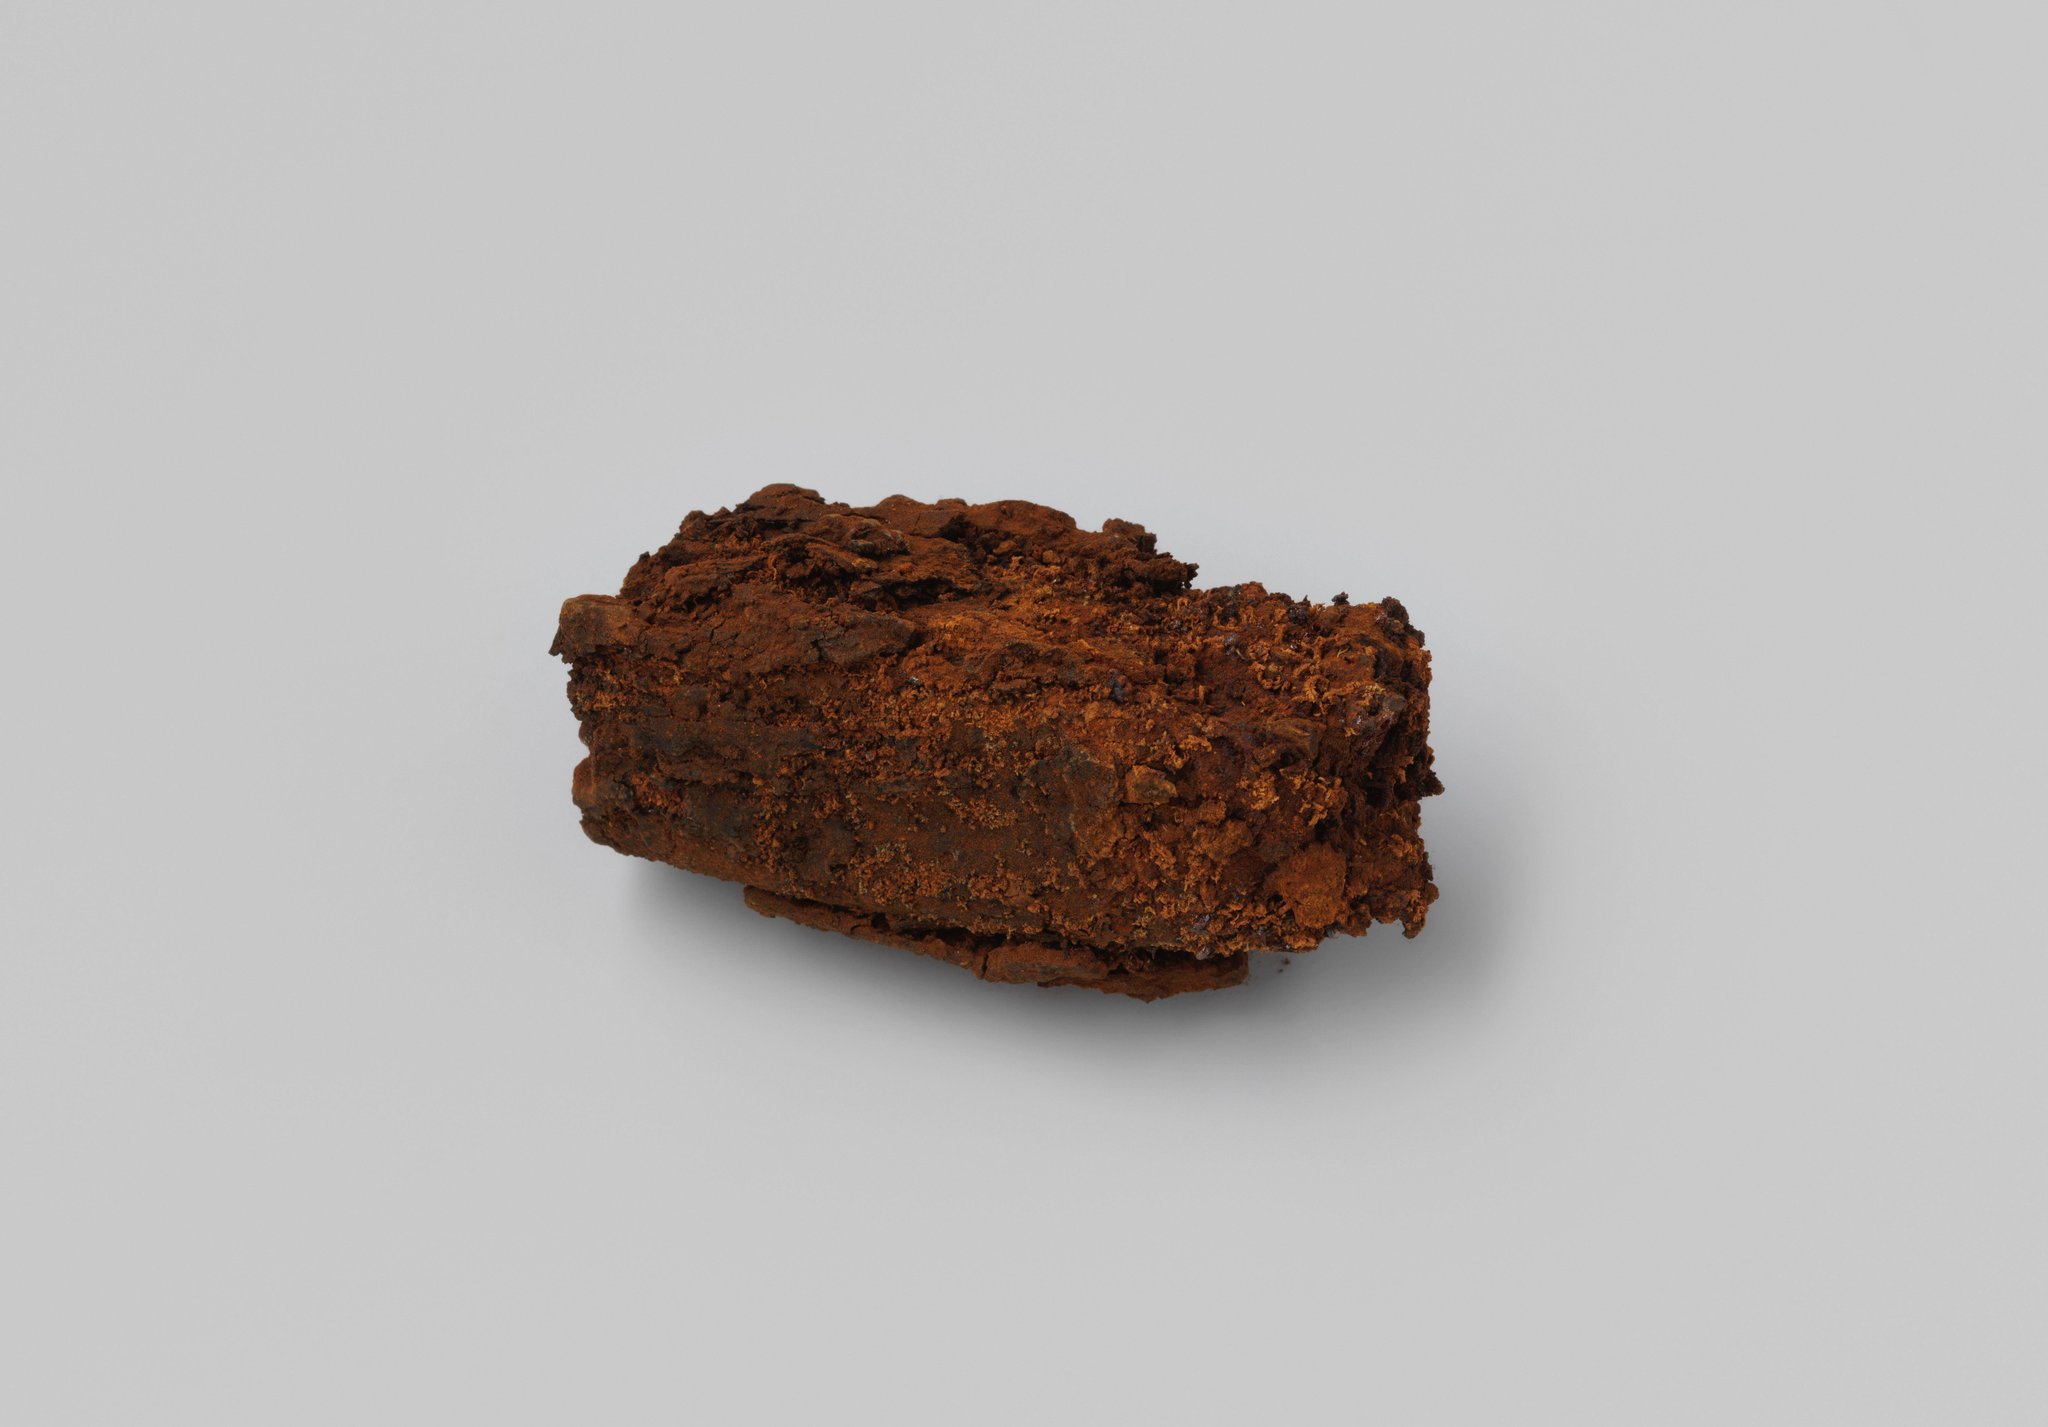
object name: fragment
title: Fragment of onderdeel uit het wrak van de Oost-Indiëvaarder Hollandia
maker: Anonymous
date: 1743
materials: iron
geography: netherlands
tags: verenigde oostindische compagnie, hollandia (schip), annet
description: Varied parts or fragments, bar(-shaped) fragments; fragm, heavily eroded, broken, sim. 80H1763.